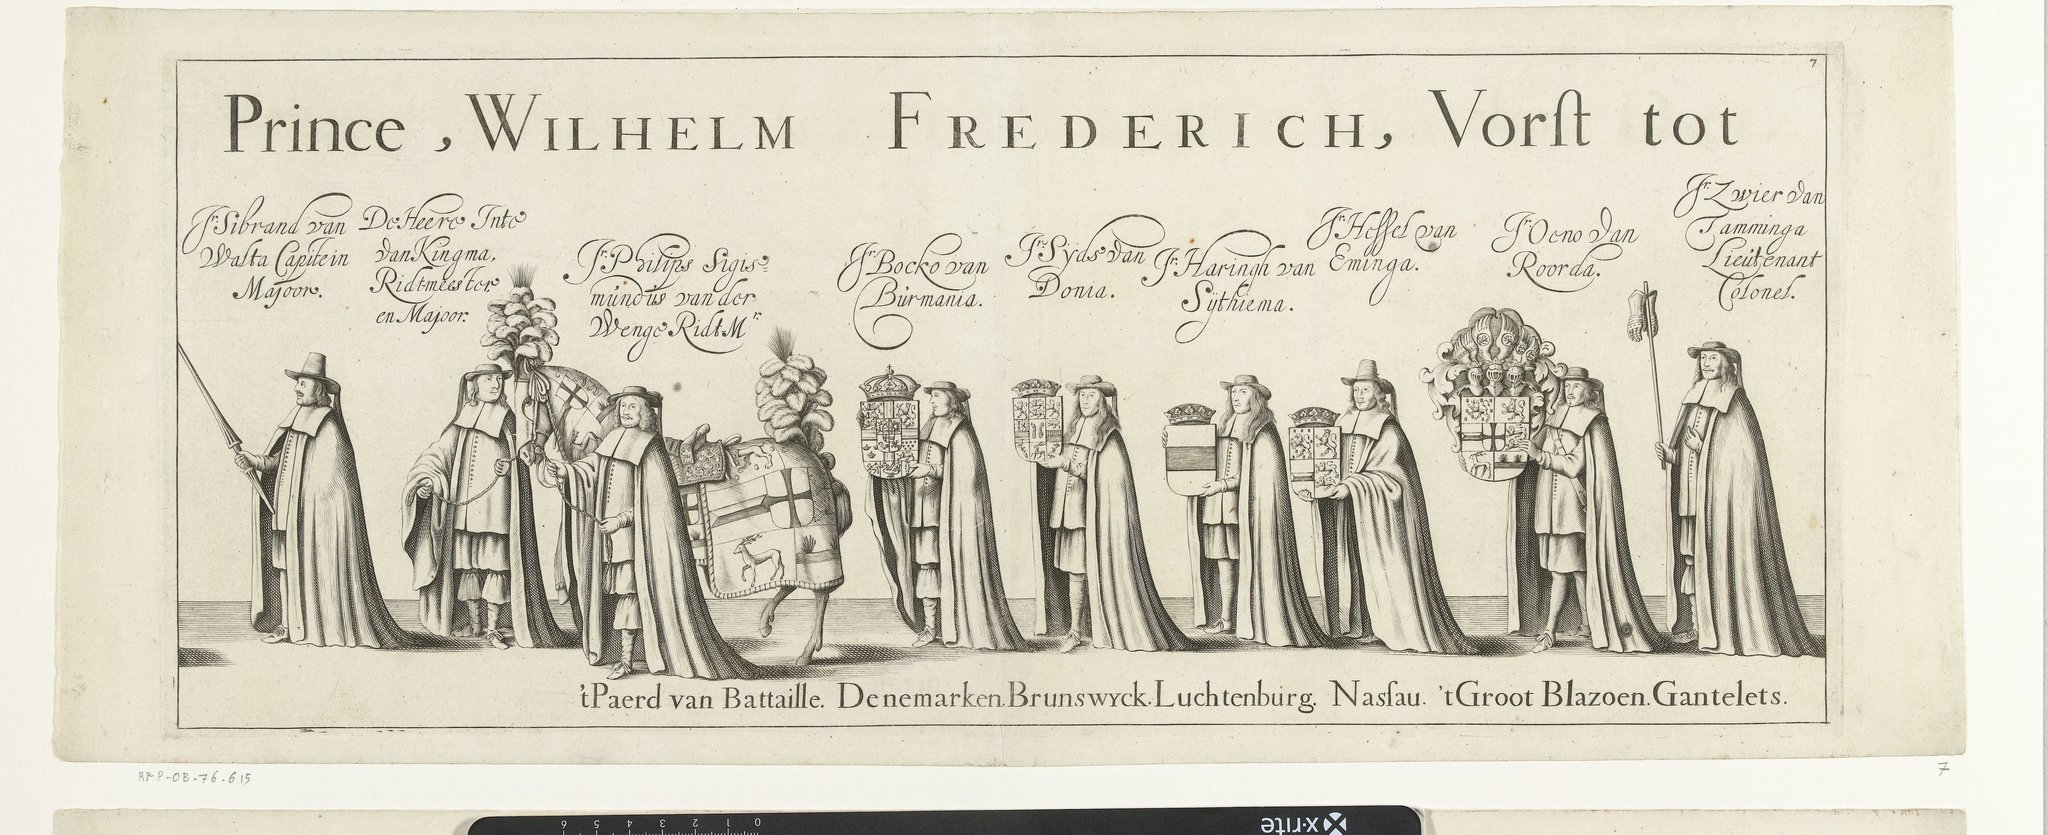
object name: print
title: Rouw-Staetelijcke Lijk-pracht in de Uyt-Vaert en Begraefenisse van het ont-zielde Lichaem van (...) Wilhelm Frederich (...) Overleden binnen Leeuwarden (...) den een-en-twintichsten October, MDCLXIV. en aldaer in 't Choor van de Jacobijner Kerck, den vyfthienden december MDCLXIV. Oude Stijl (...)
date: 1666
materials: paper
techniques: engraving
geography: leeuwarden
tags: arnhem, cortege, funeral procession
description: Begrafenisoptocht van Willem Frederik, graaf van Nassau-Dietz, in Leeuwarden op 6 januari 1665. Deel van de begrafenisstoet. Plaat nr. 7 in een ensemble van 25 ongemonteerde genummerde platen en twee tekstbladen die samen een lange fries vormen.